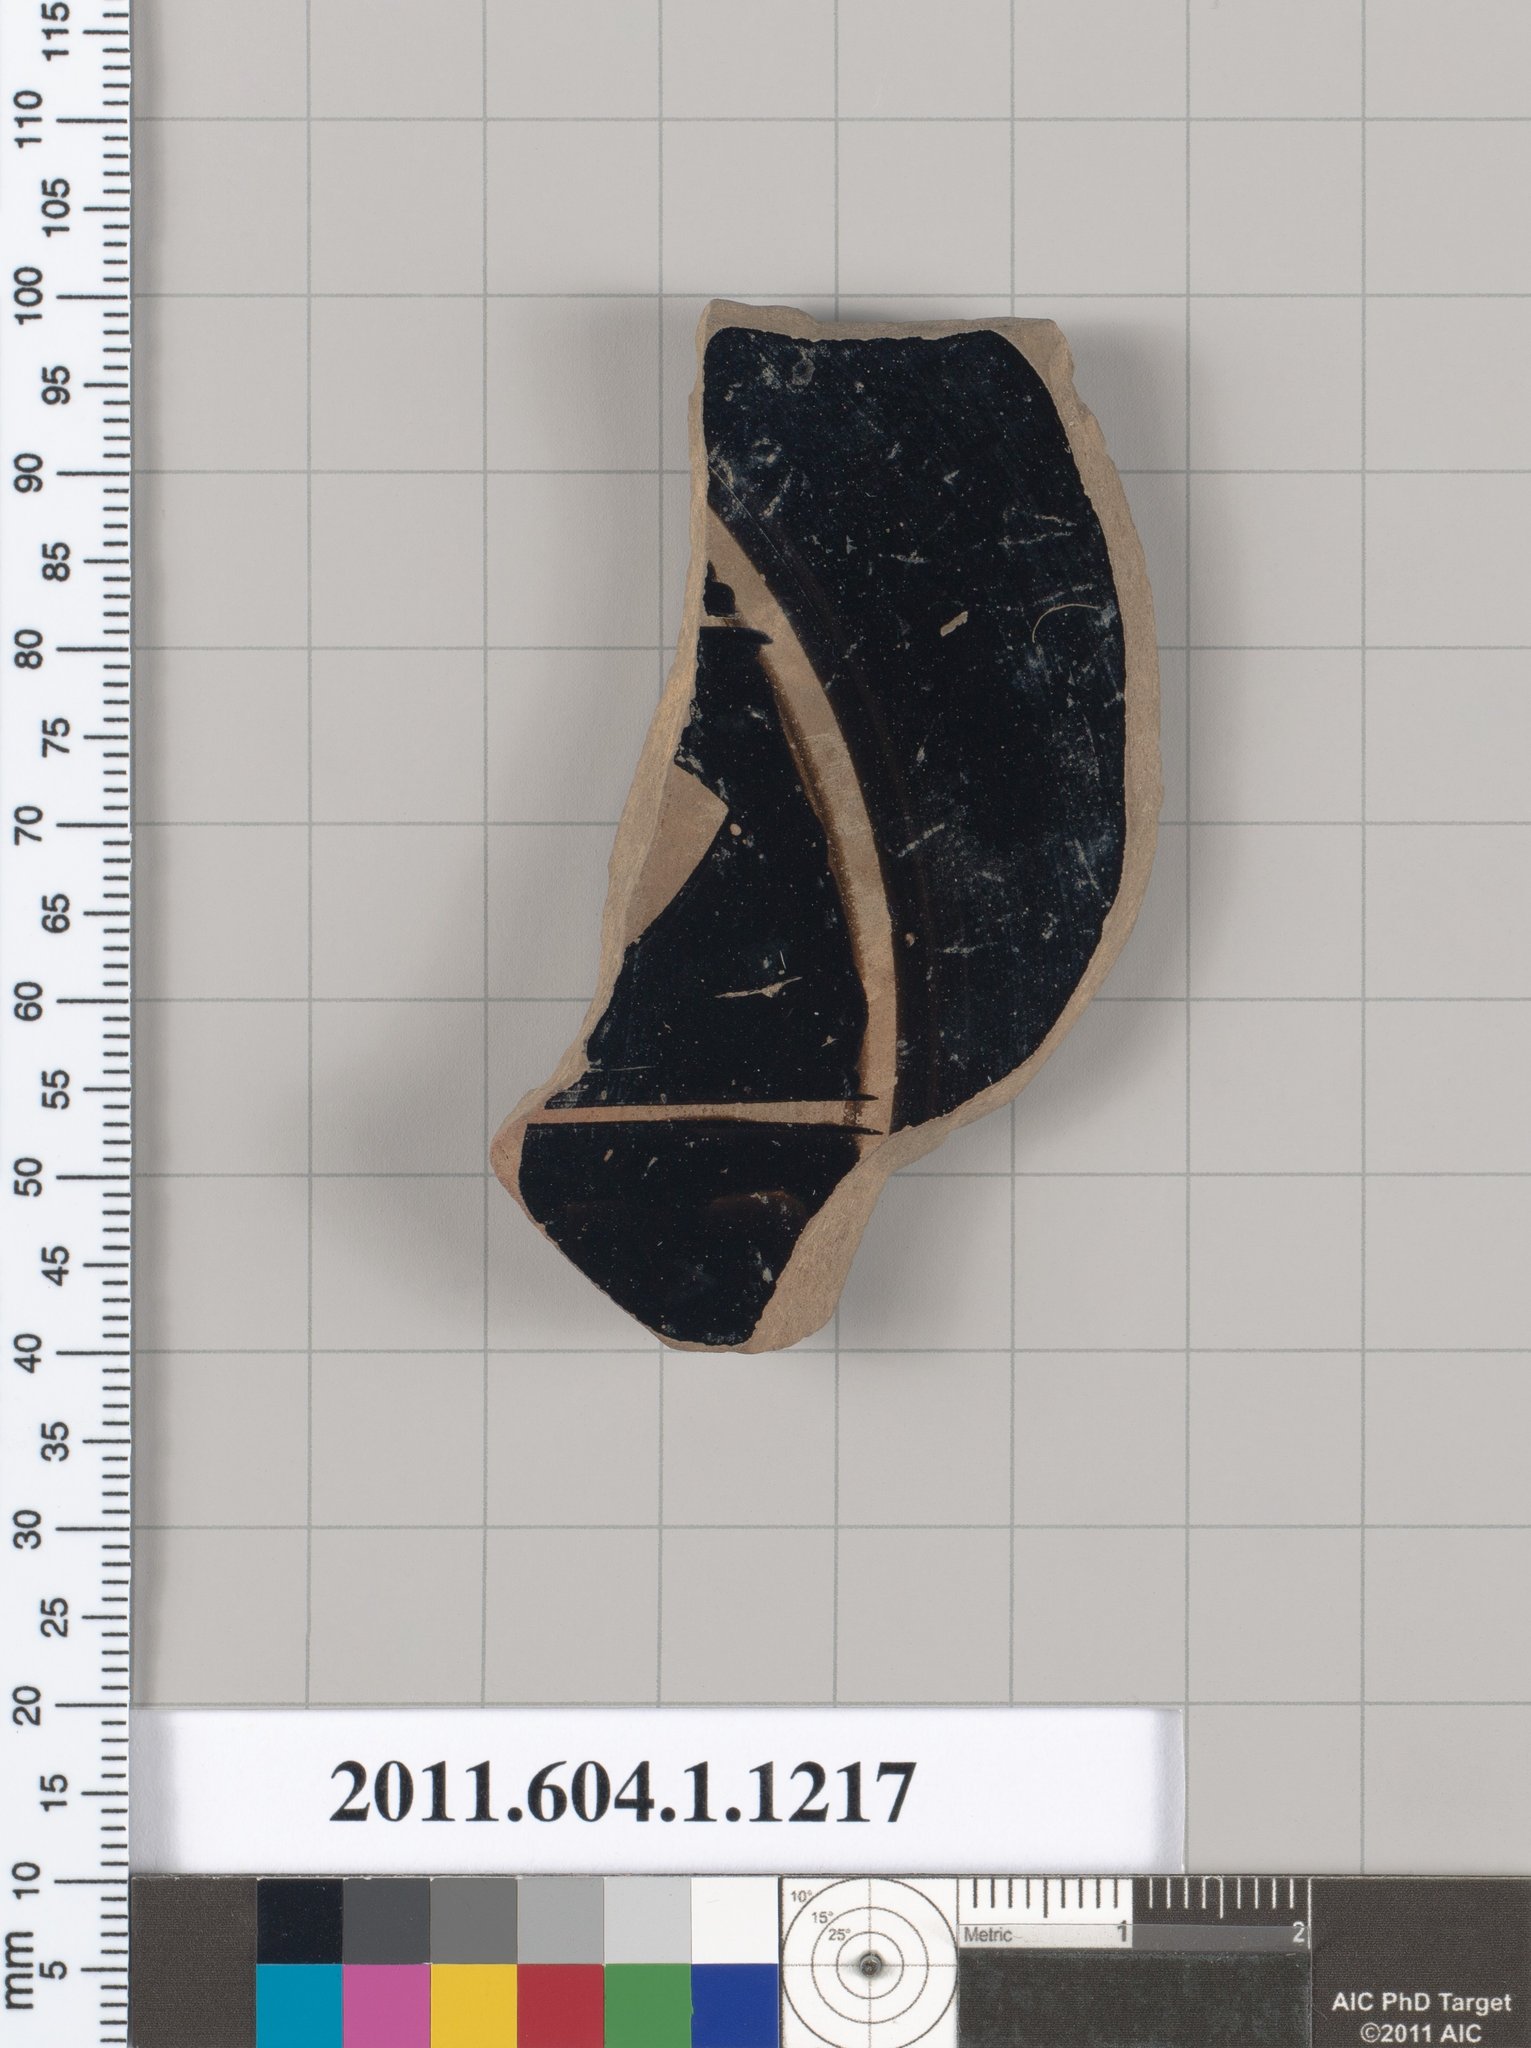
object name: kylix fragment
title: Terracotta fragment of a kylix (drinking cup)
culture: greek, attic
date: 520-500 BCE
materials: terracotta